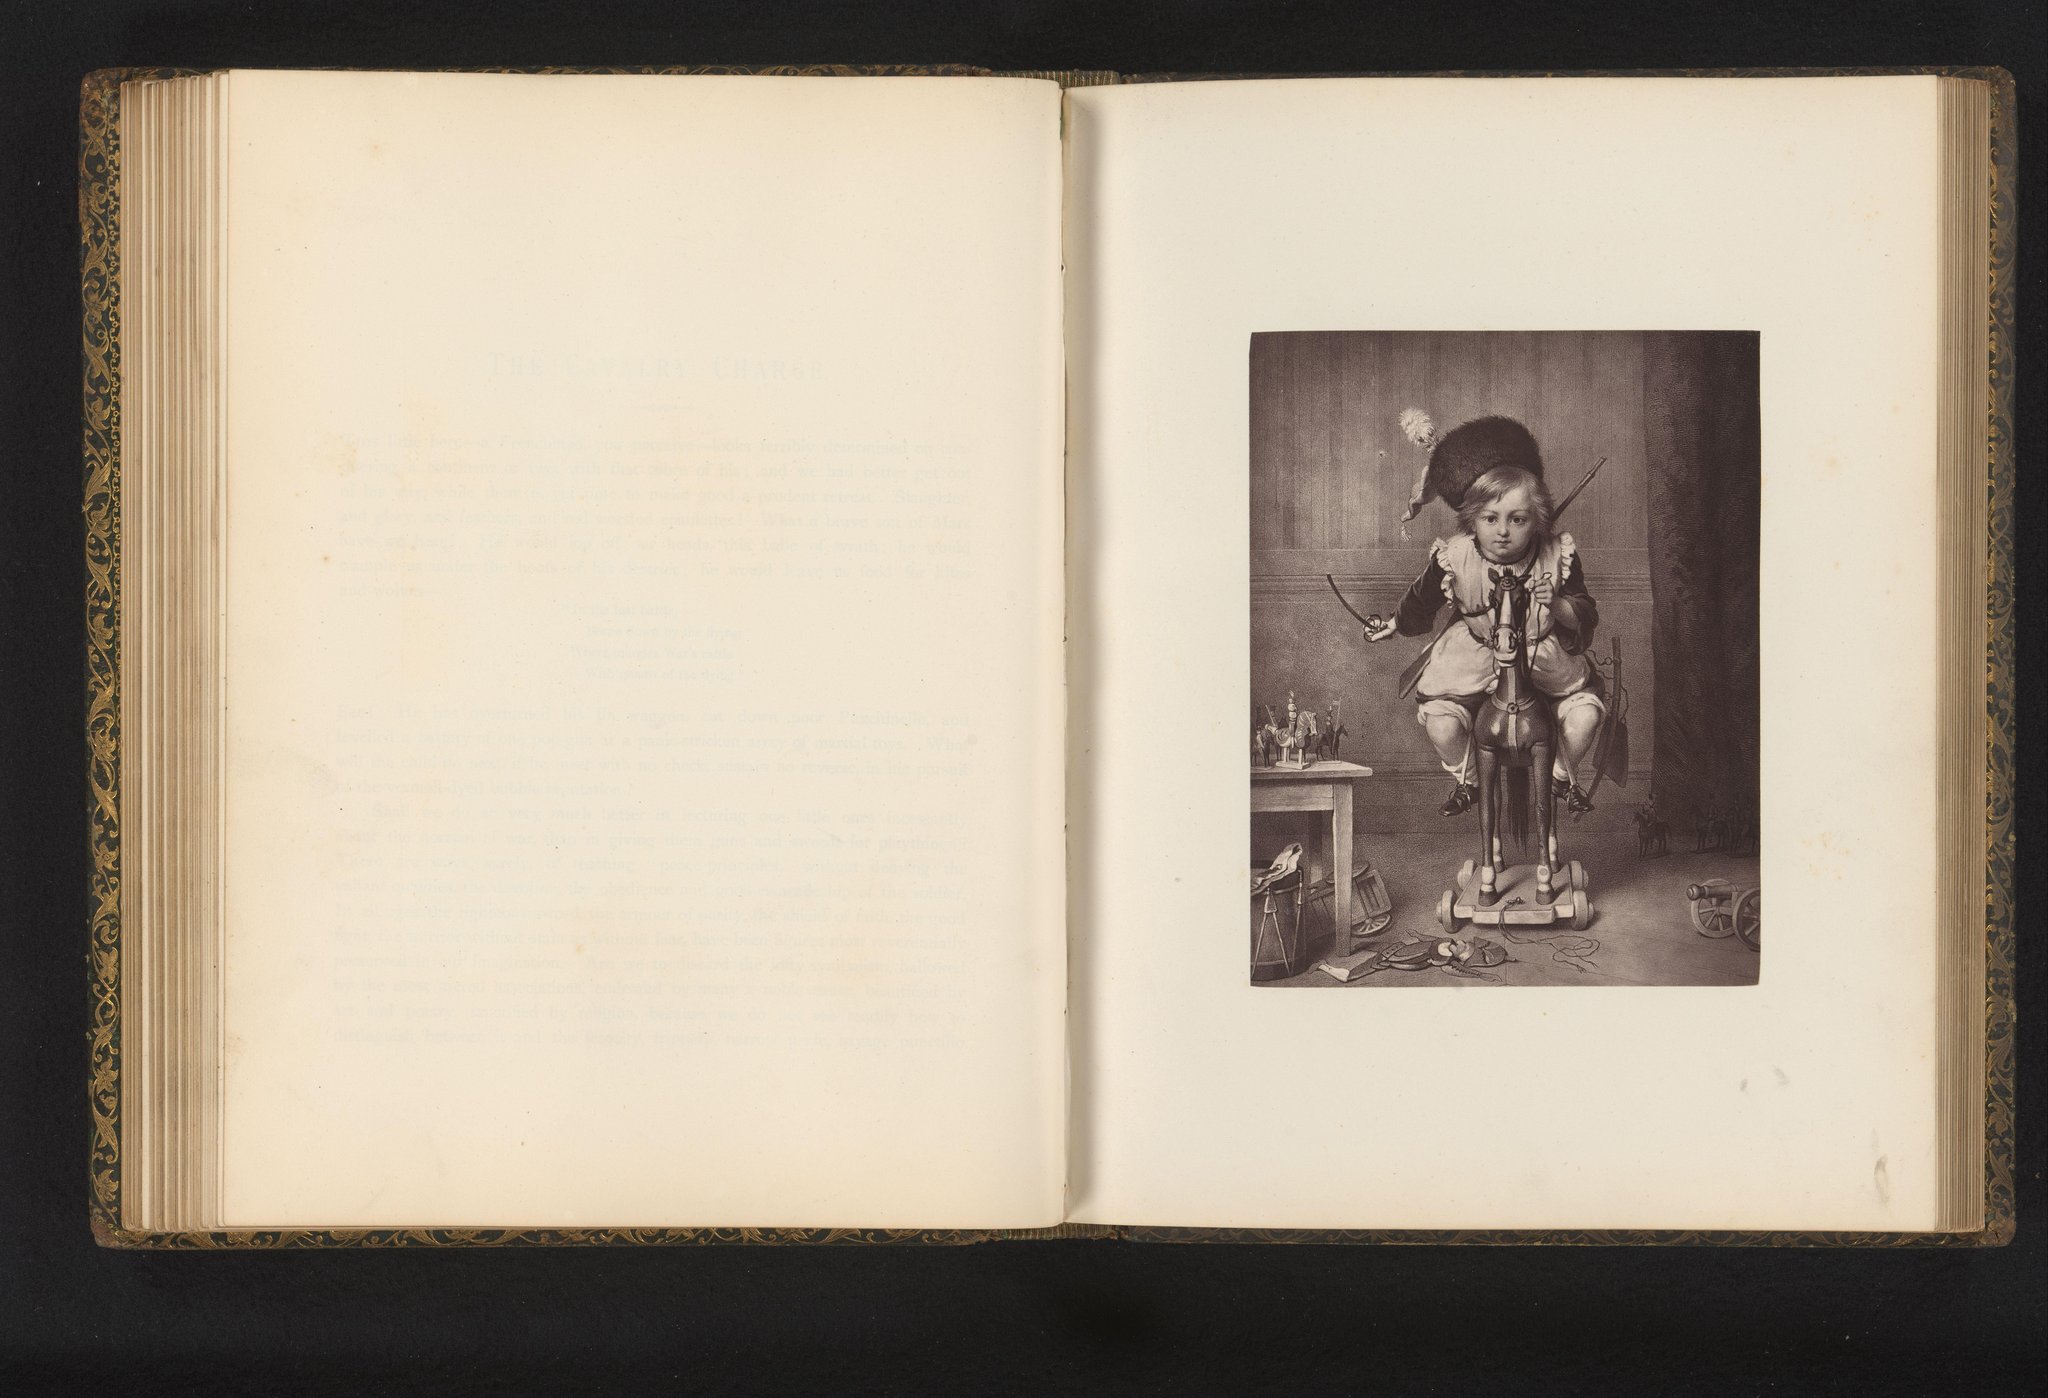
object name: reproduction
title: Fotoreproductie van een prent naar het schilderij The cavalry charge door Adolphe Dubasty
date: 1866-1871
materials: paper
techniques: woodburytype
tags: sabre (~ fencing), hobby-horse, print, e.g.: engraving, etching, lithograph, child (at home)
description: Prent op derde ongenummerde pagina na pagina 70.